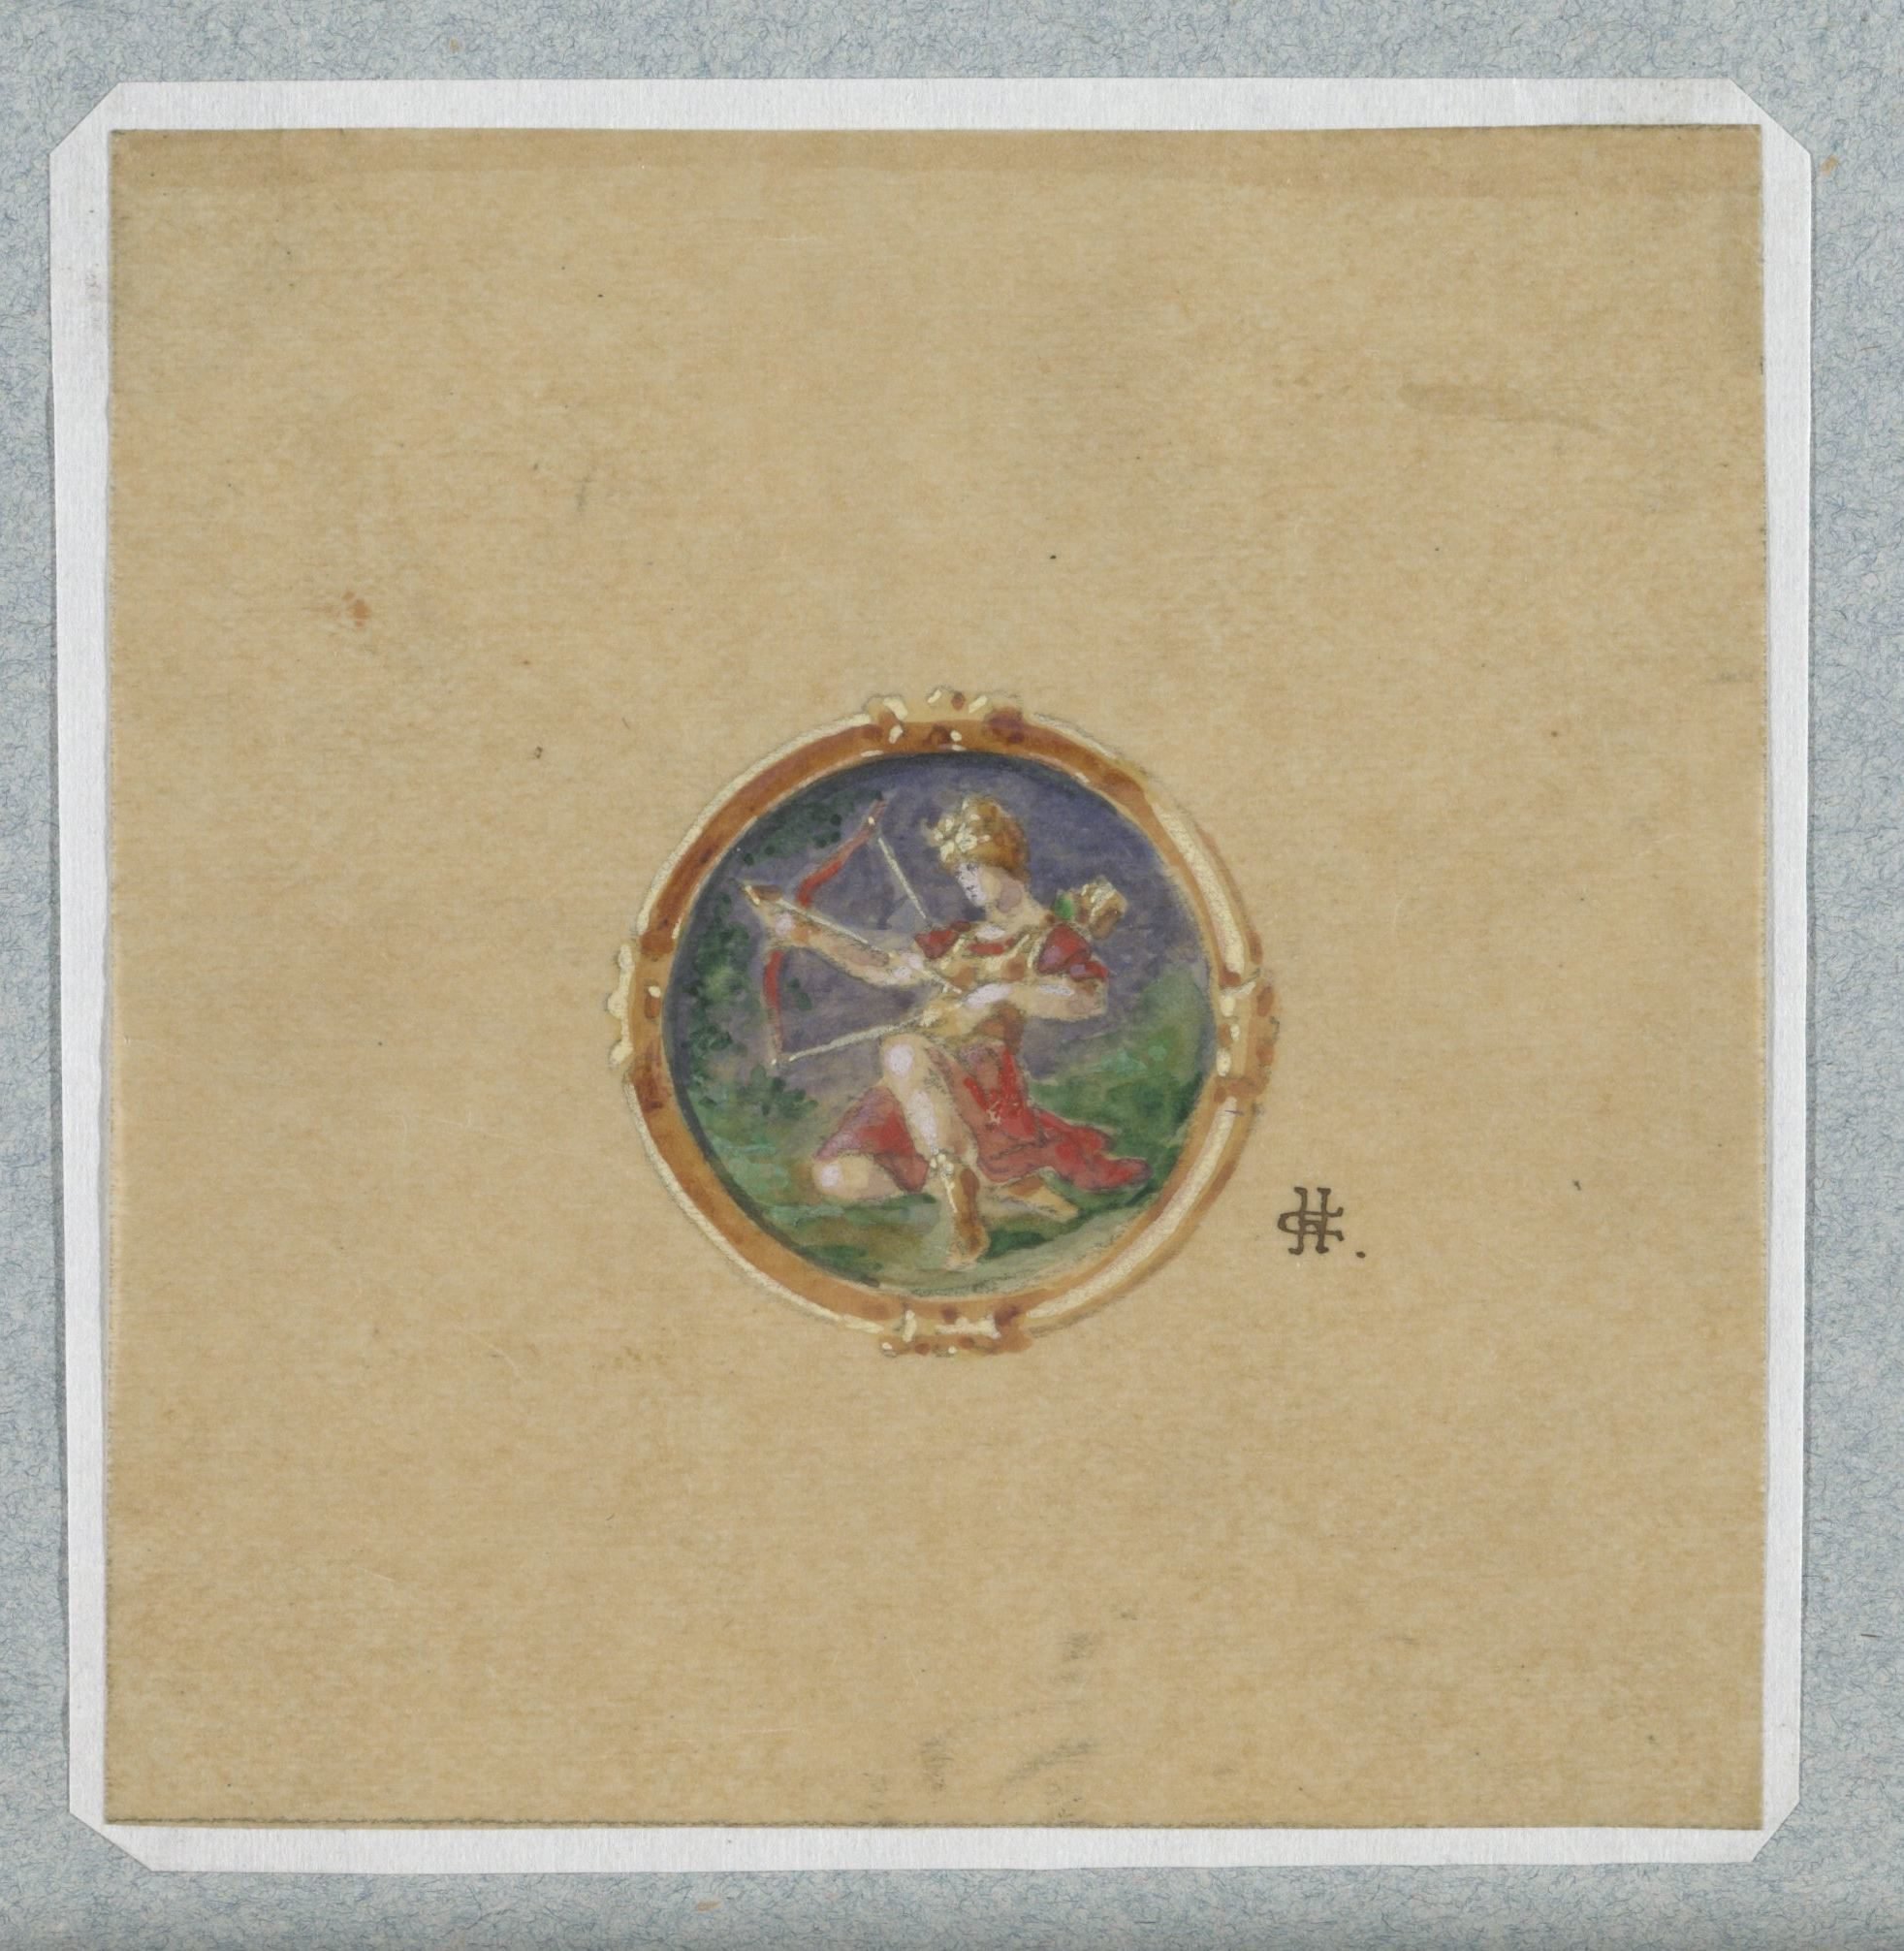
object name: design drawing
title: Design for a Medallion with Cupid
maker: henri cameré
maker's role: designer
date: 1864-1894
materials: paint, pencil, paper, watercolor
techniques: brush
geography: paris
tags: cupids: 'amores', 'amoretti', 'putti'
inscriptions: monogram: ‘HC’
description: In the 16th century this type of medallion (agrafe) was mostly worn by men and fastened to the brim of their hats. In terms of its form, this design for a gold and colourfully enamelled medallion was inspired by examples from the Renaissance. However, the kneeling Cupid armed with bow and arrow lends this design that touch of romance that people were so fond of in the 19th century.